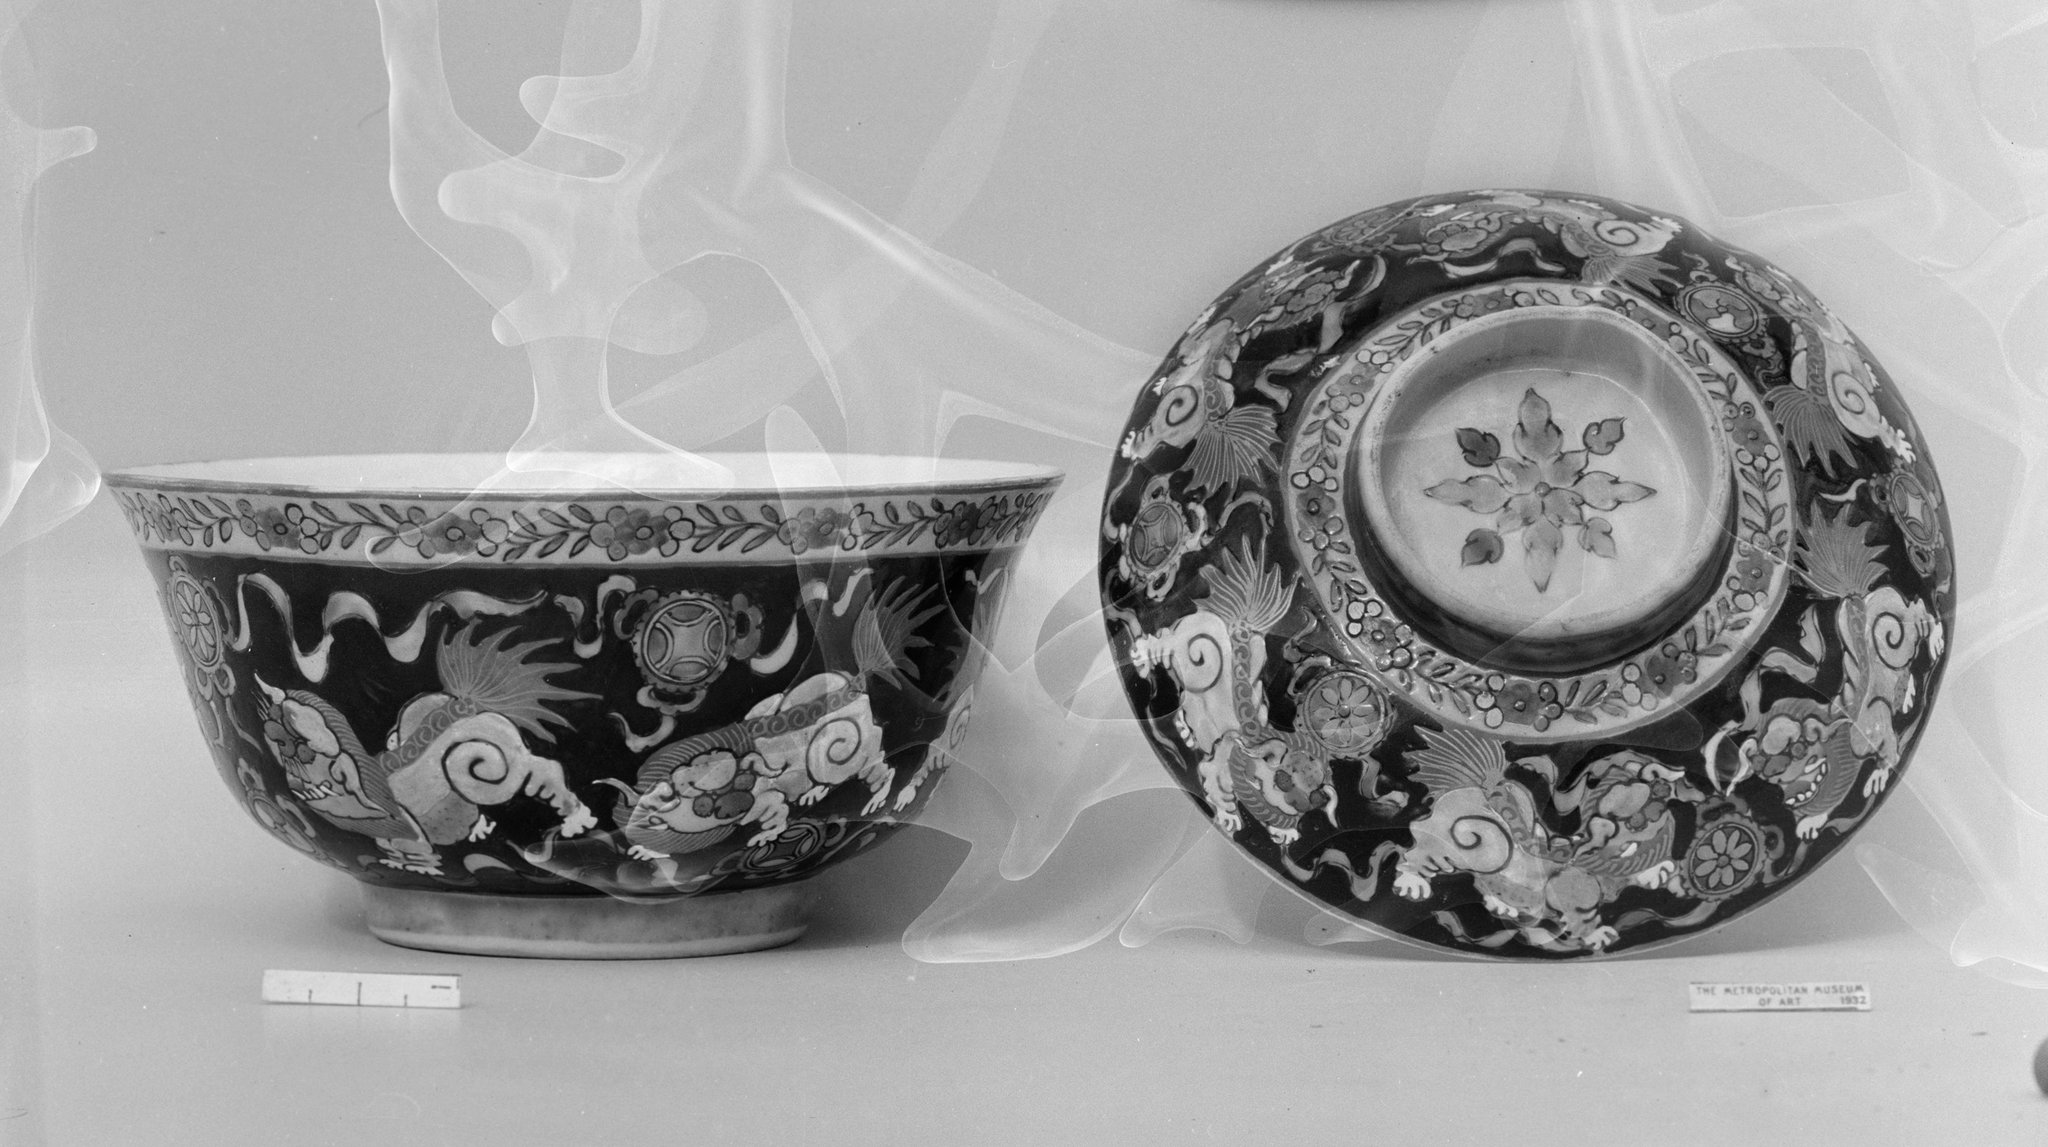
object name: covered bowl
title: Covered bowl with lions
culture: chinese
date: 1801-1900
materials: enamel, porcelain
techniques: overglaze, painting, polychrome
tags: lions